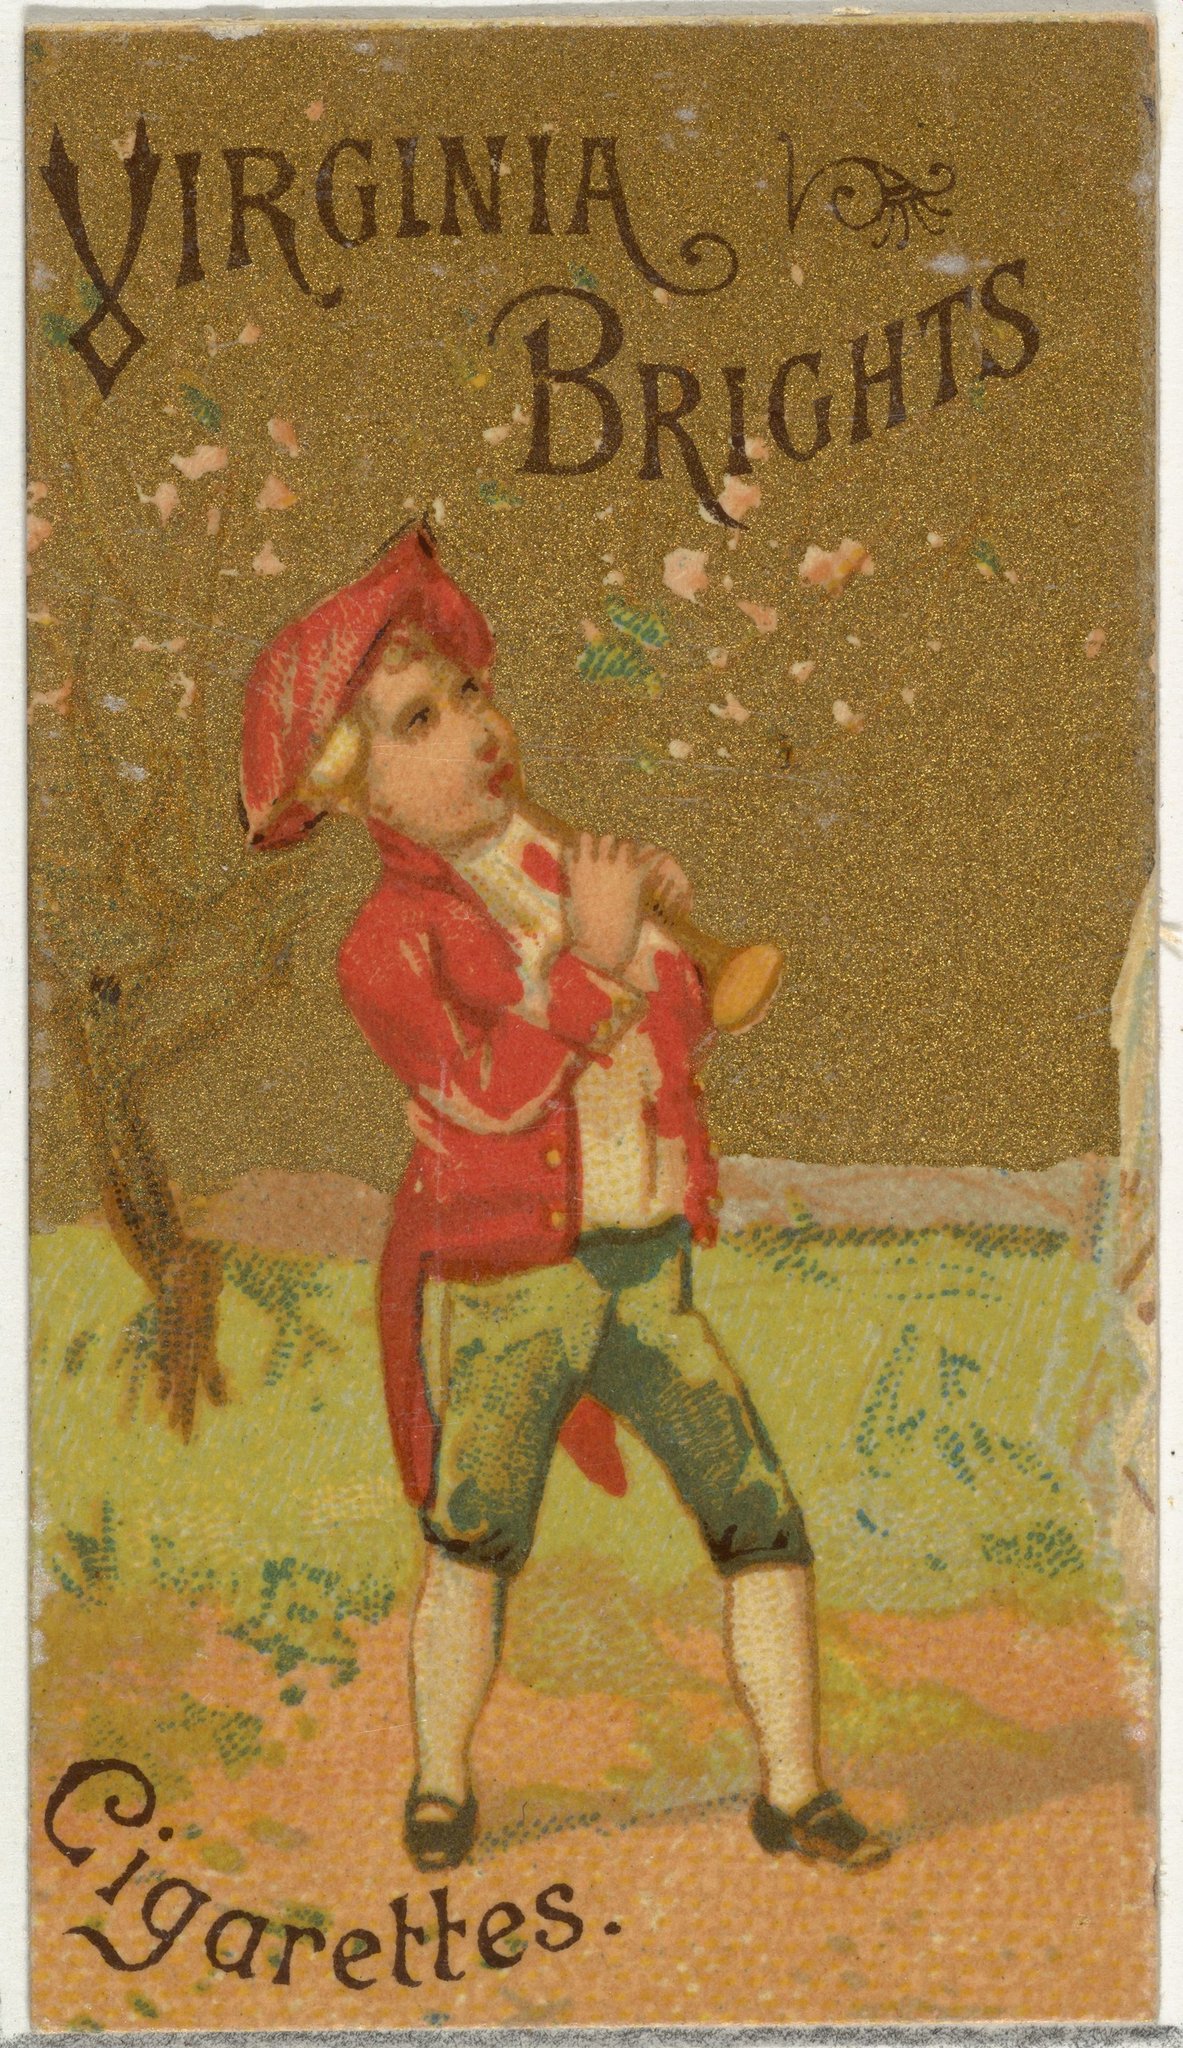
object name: print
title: From the Girls and Children series (N64) promoting Virginia Brights Cigarettes for Allen & Ginter brand tobacco products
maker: allen & ginter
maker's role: publisher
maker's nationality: american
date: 1886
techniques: color lithograph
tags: musical instruments,girls